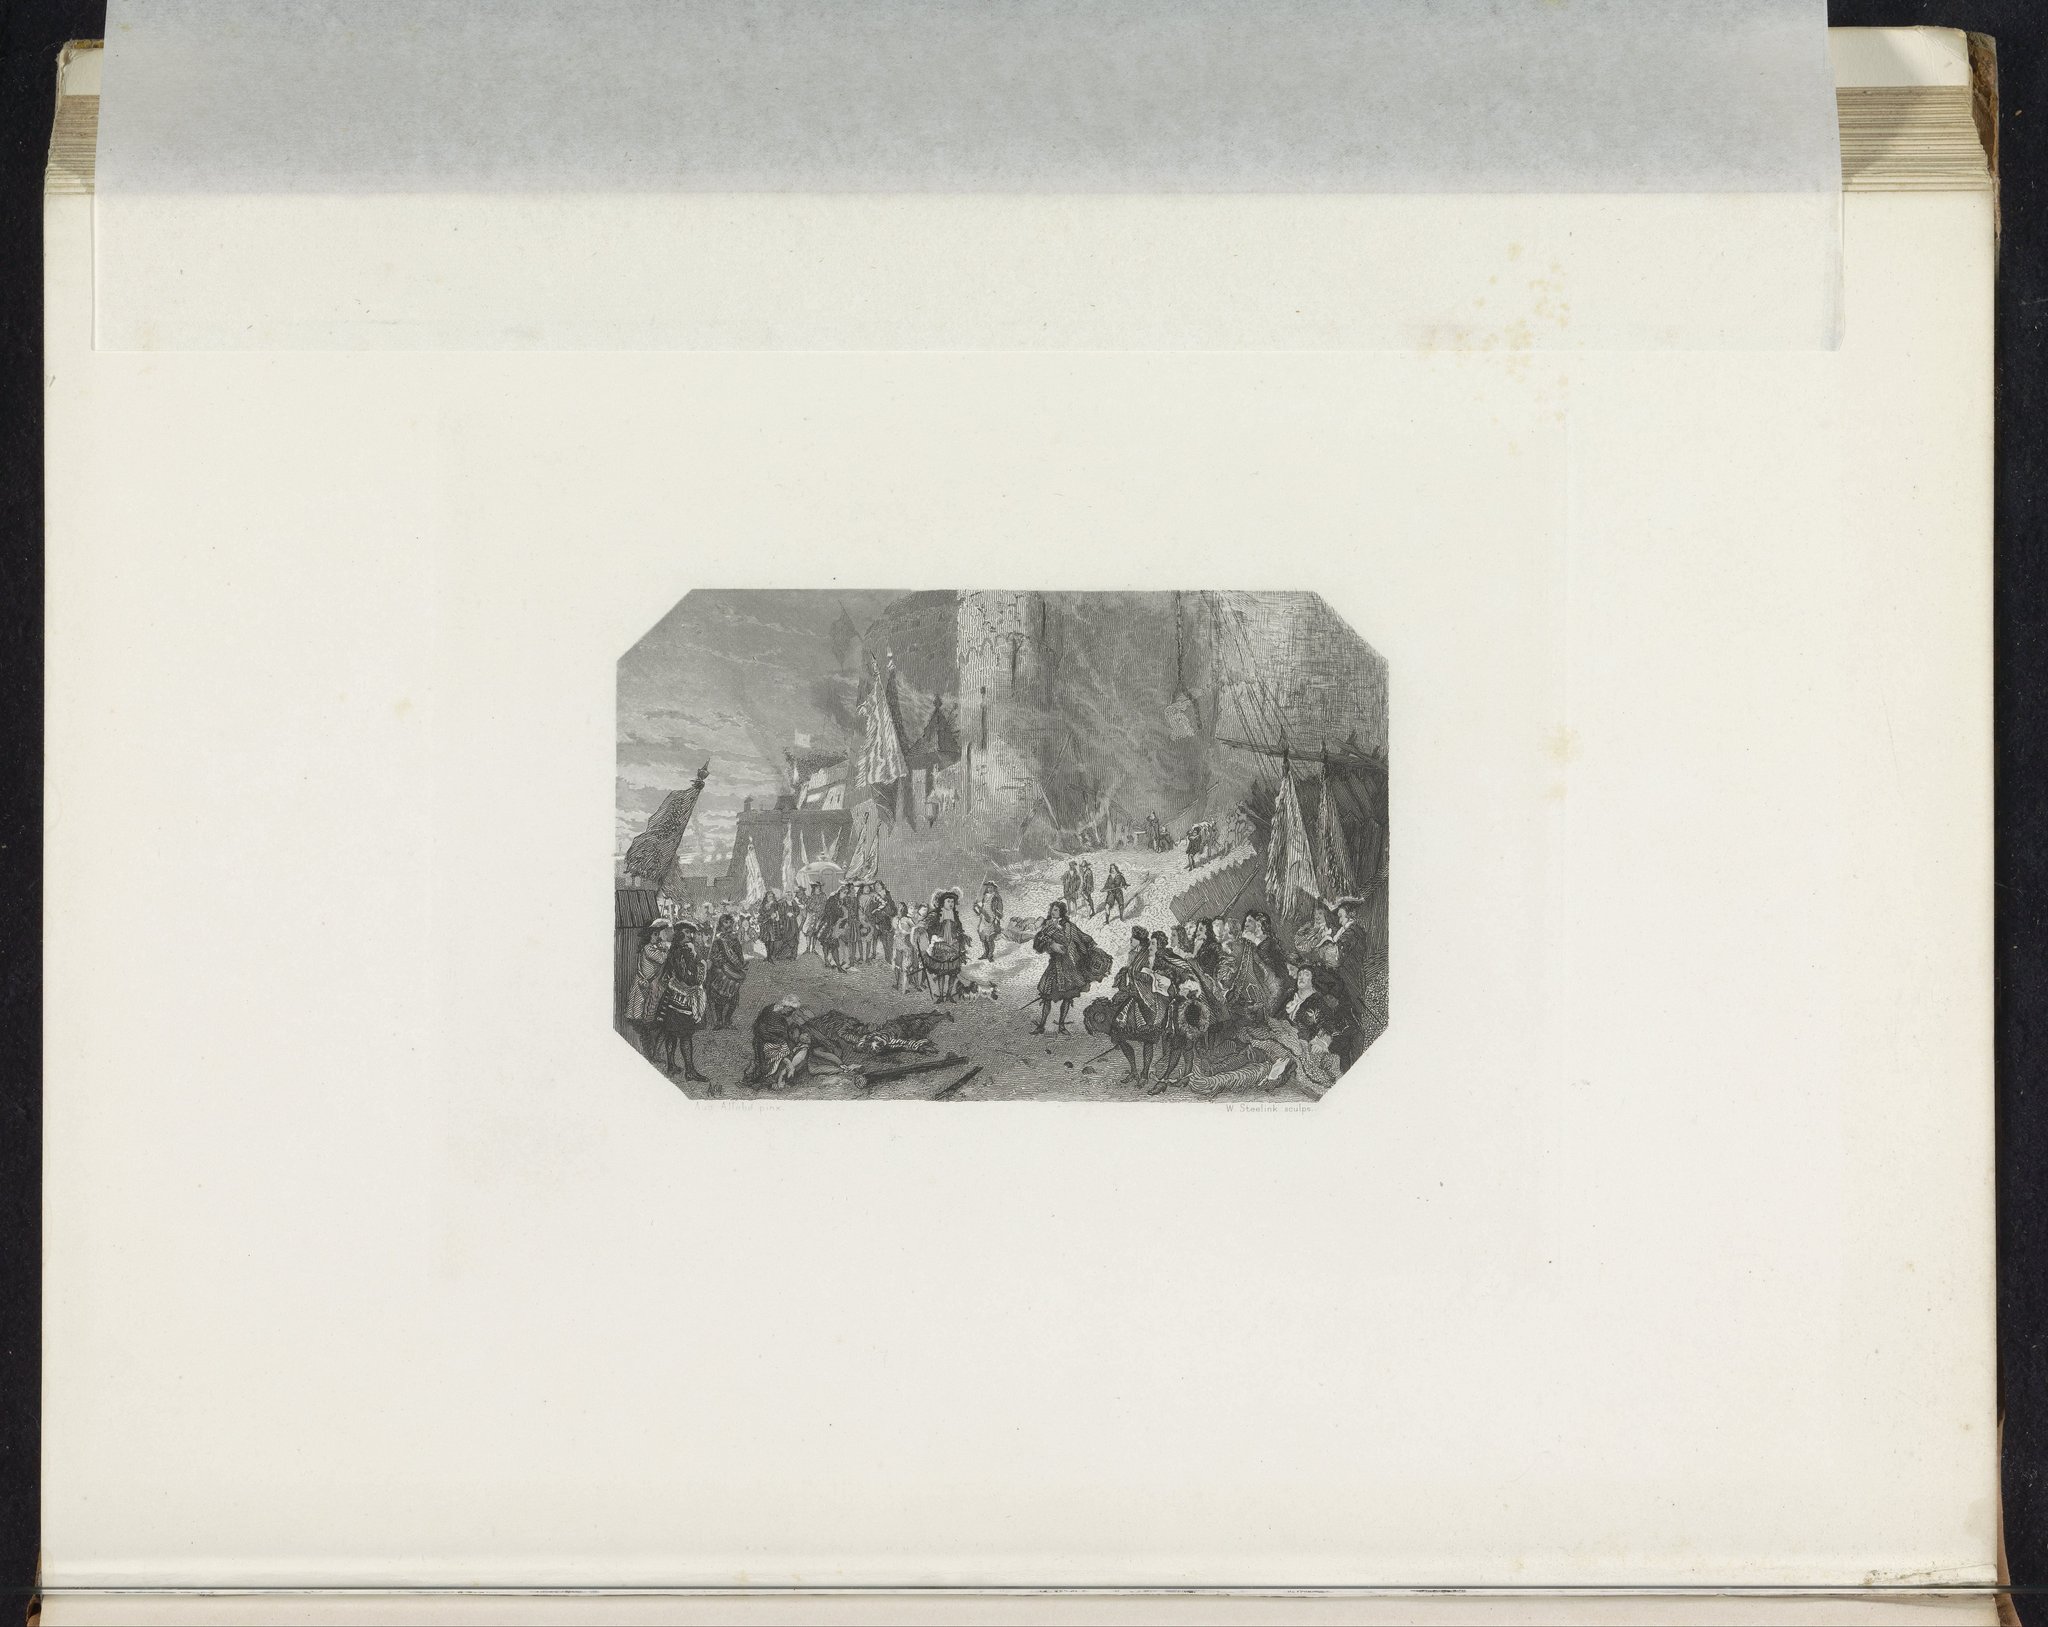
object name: history print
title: Menno van Coehoorn, te Namen, 1692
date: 1865-1870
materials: paper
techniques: engraving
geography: netherlands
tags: lodewijk xiv (koning van frankrijk), the hague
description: Menno van Coehoorn ontmoet koning Lodewijk XIV na het verlies van Namen na beleg aan de Fransen, 30 juni 1692. Onderdeel van de groep staalgravures naar de schilderijen van de Historische Galerij der Maatschappij Arti et Amicitiae.